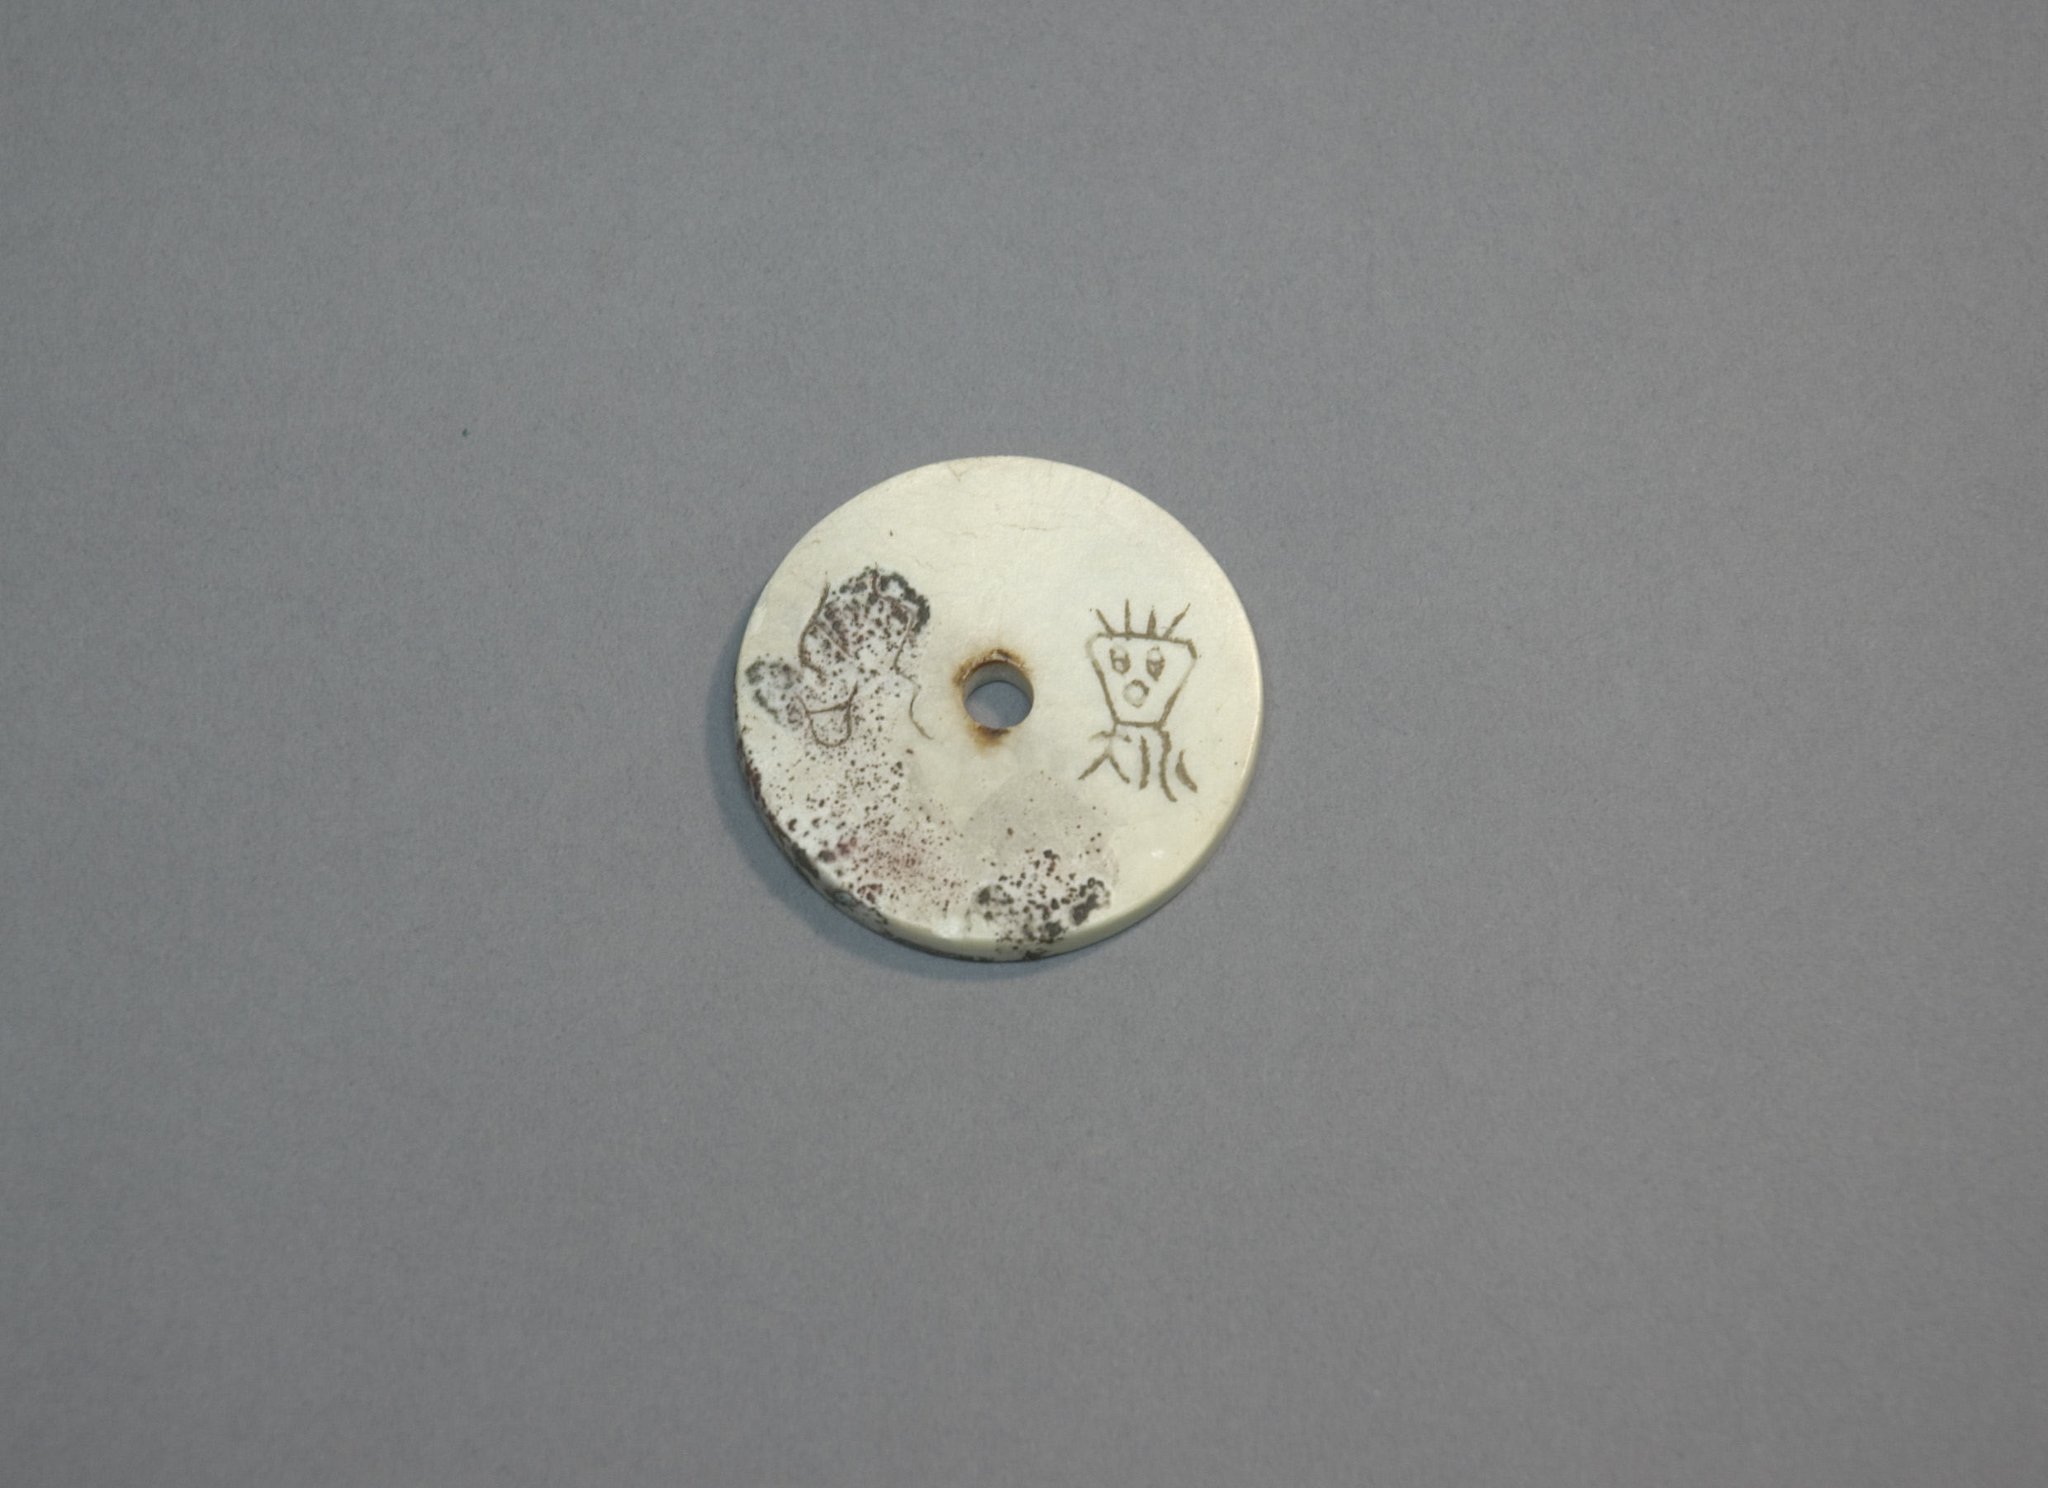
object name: jade carving material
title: Sample of "False Jade(?) Limestone"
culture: chinese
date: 1901-2000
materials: jade, limestone